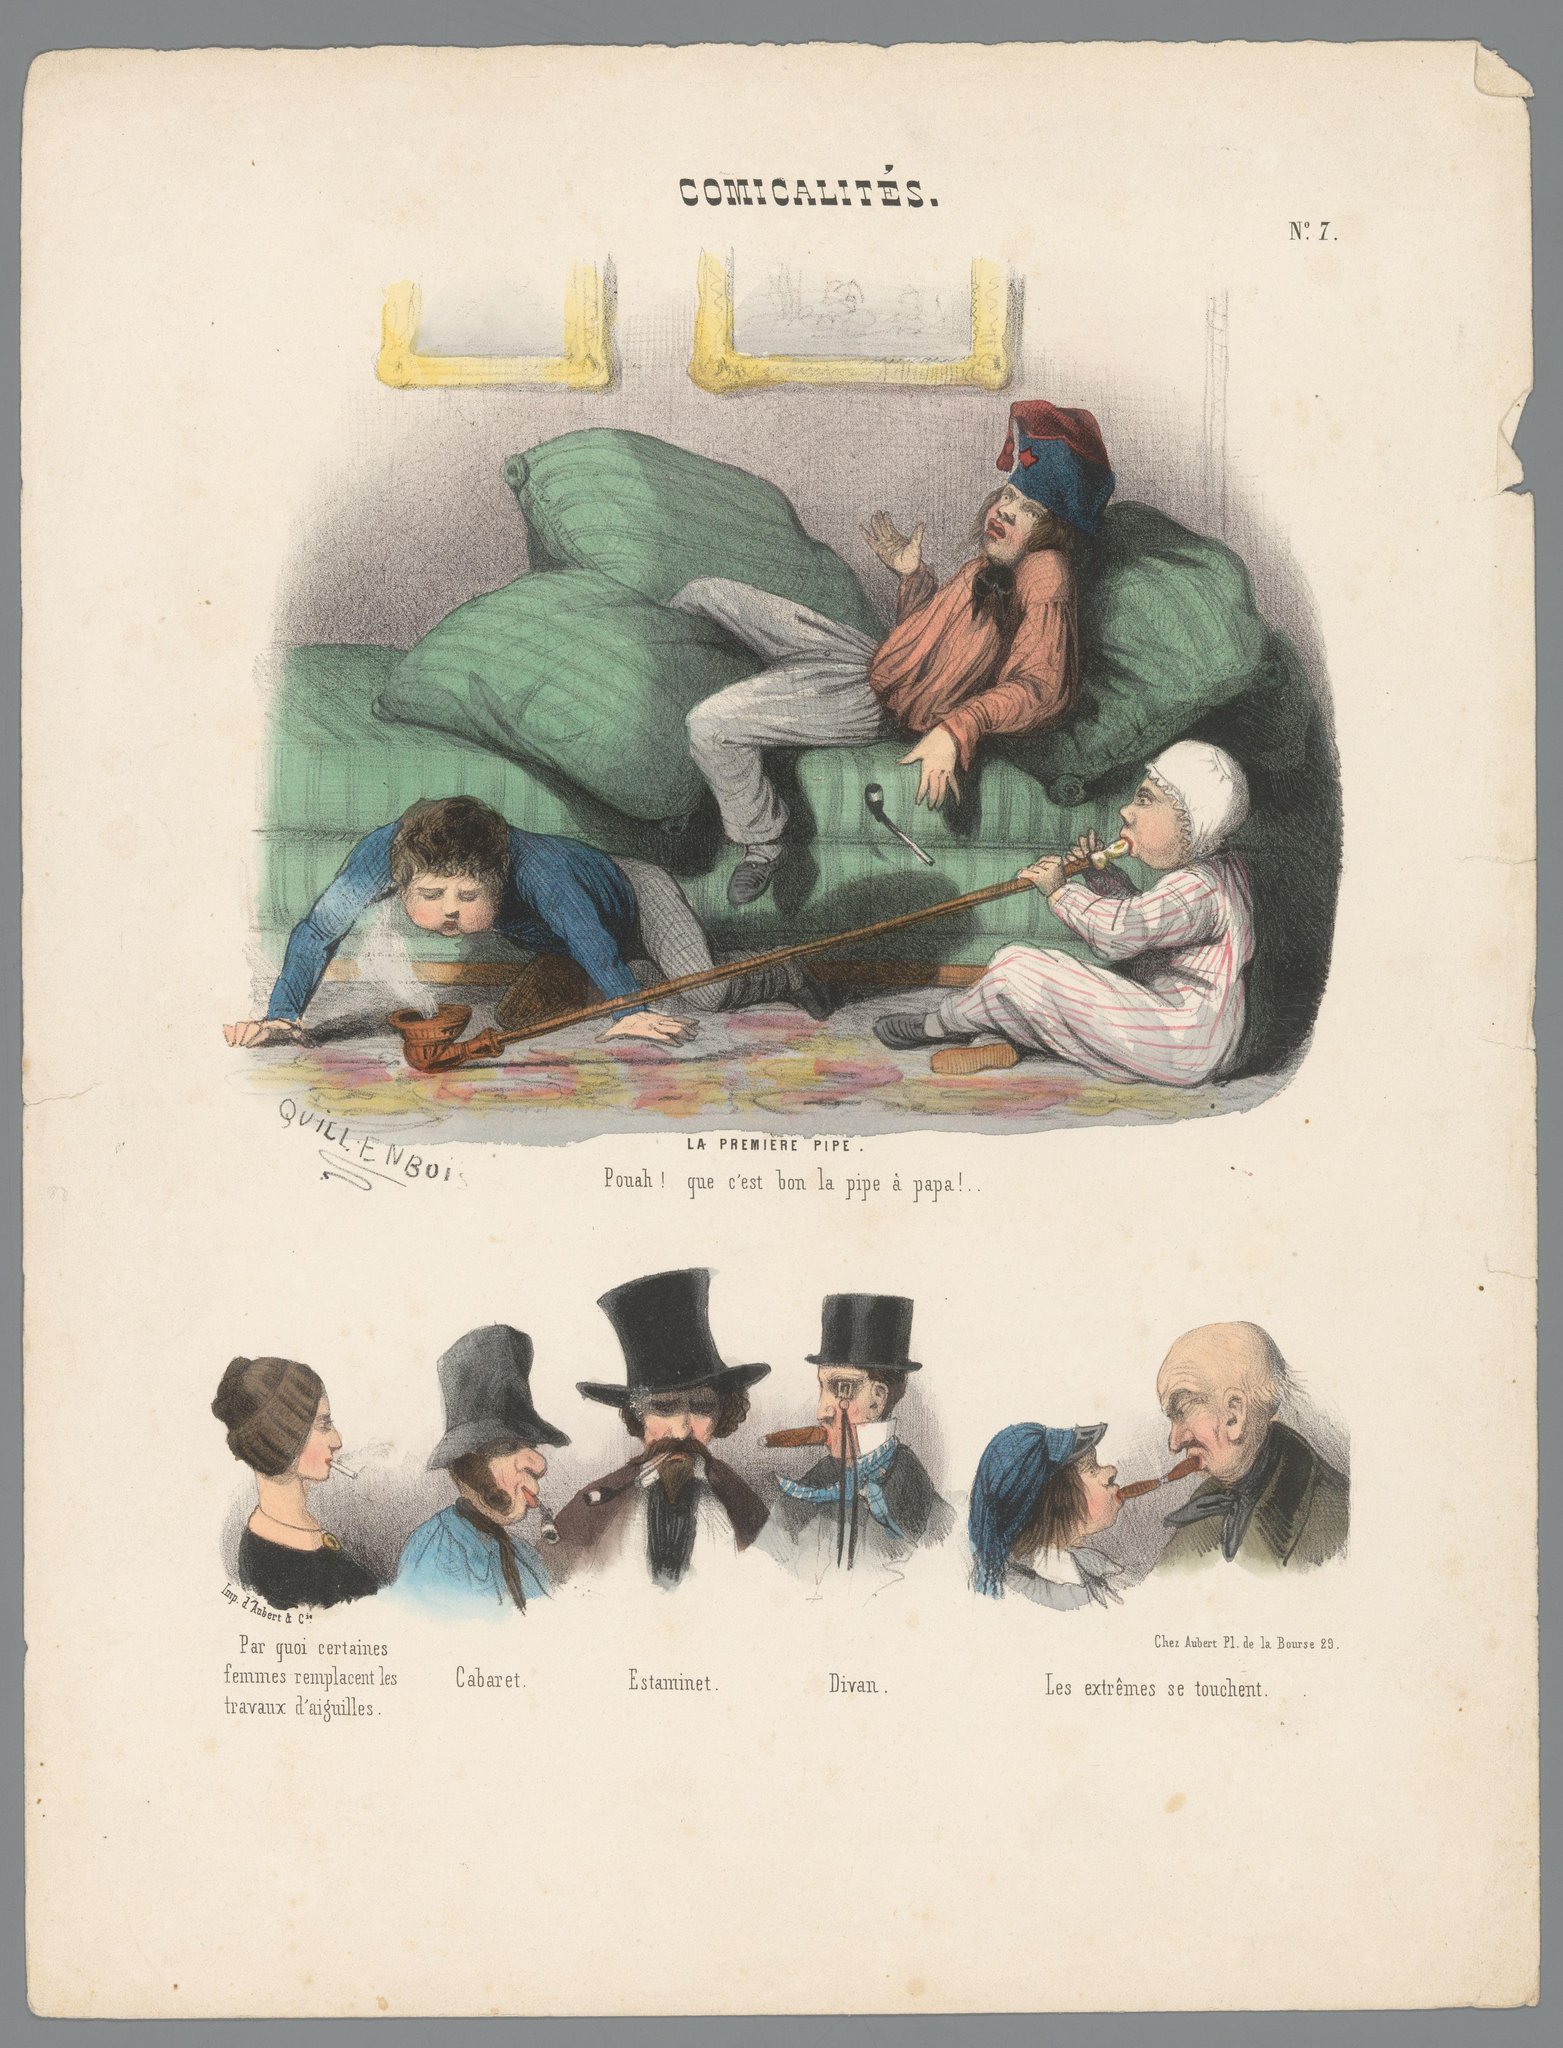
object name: cartoon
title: Diverse taferelen met betrekking tot roken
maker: quillenbois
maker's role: print maker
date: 1845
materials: paper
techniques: hand coloring, lithograph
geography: paris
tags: cigar, cigarette, pipe ~ tobacco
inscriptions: collector's mark: Lugt 2233